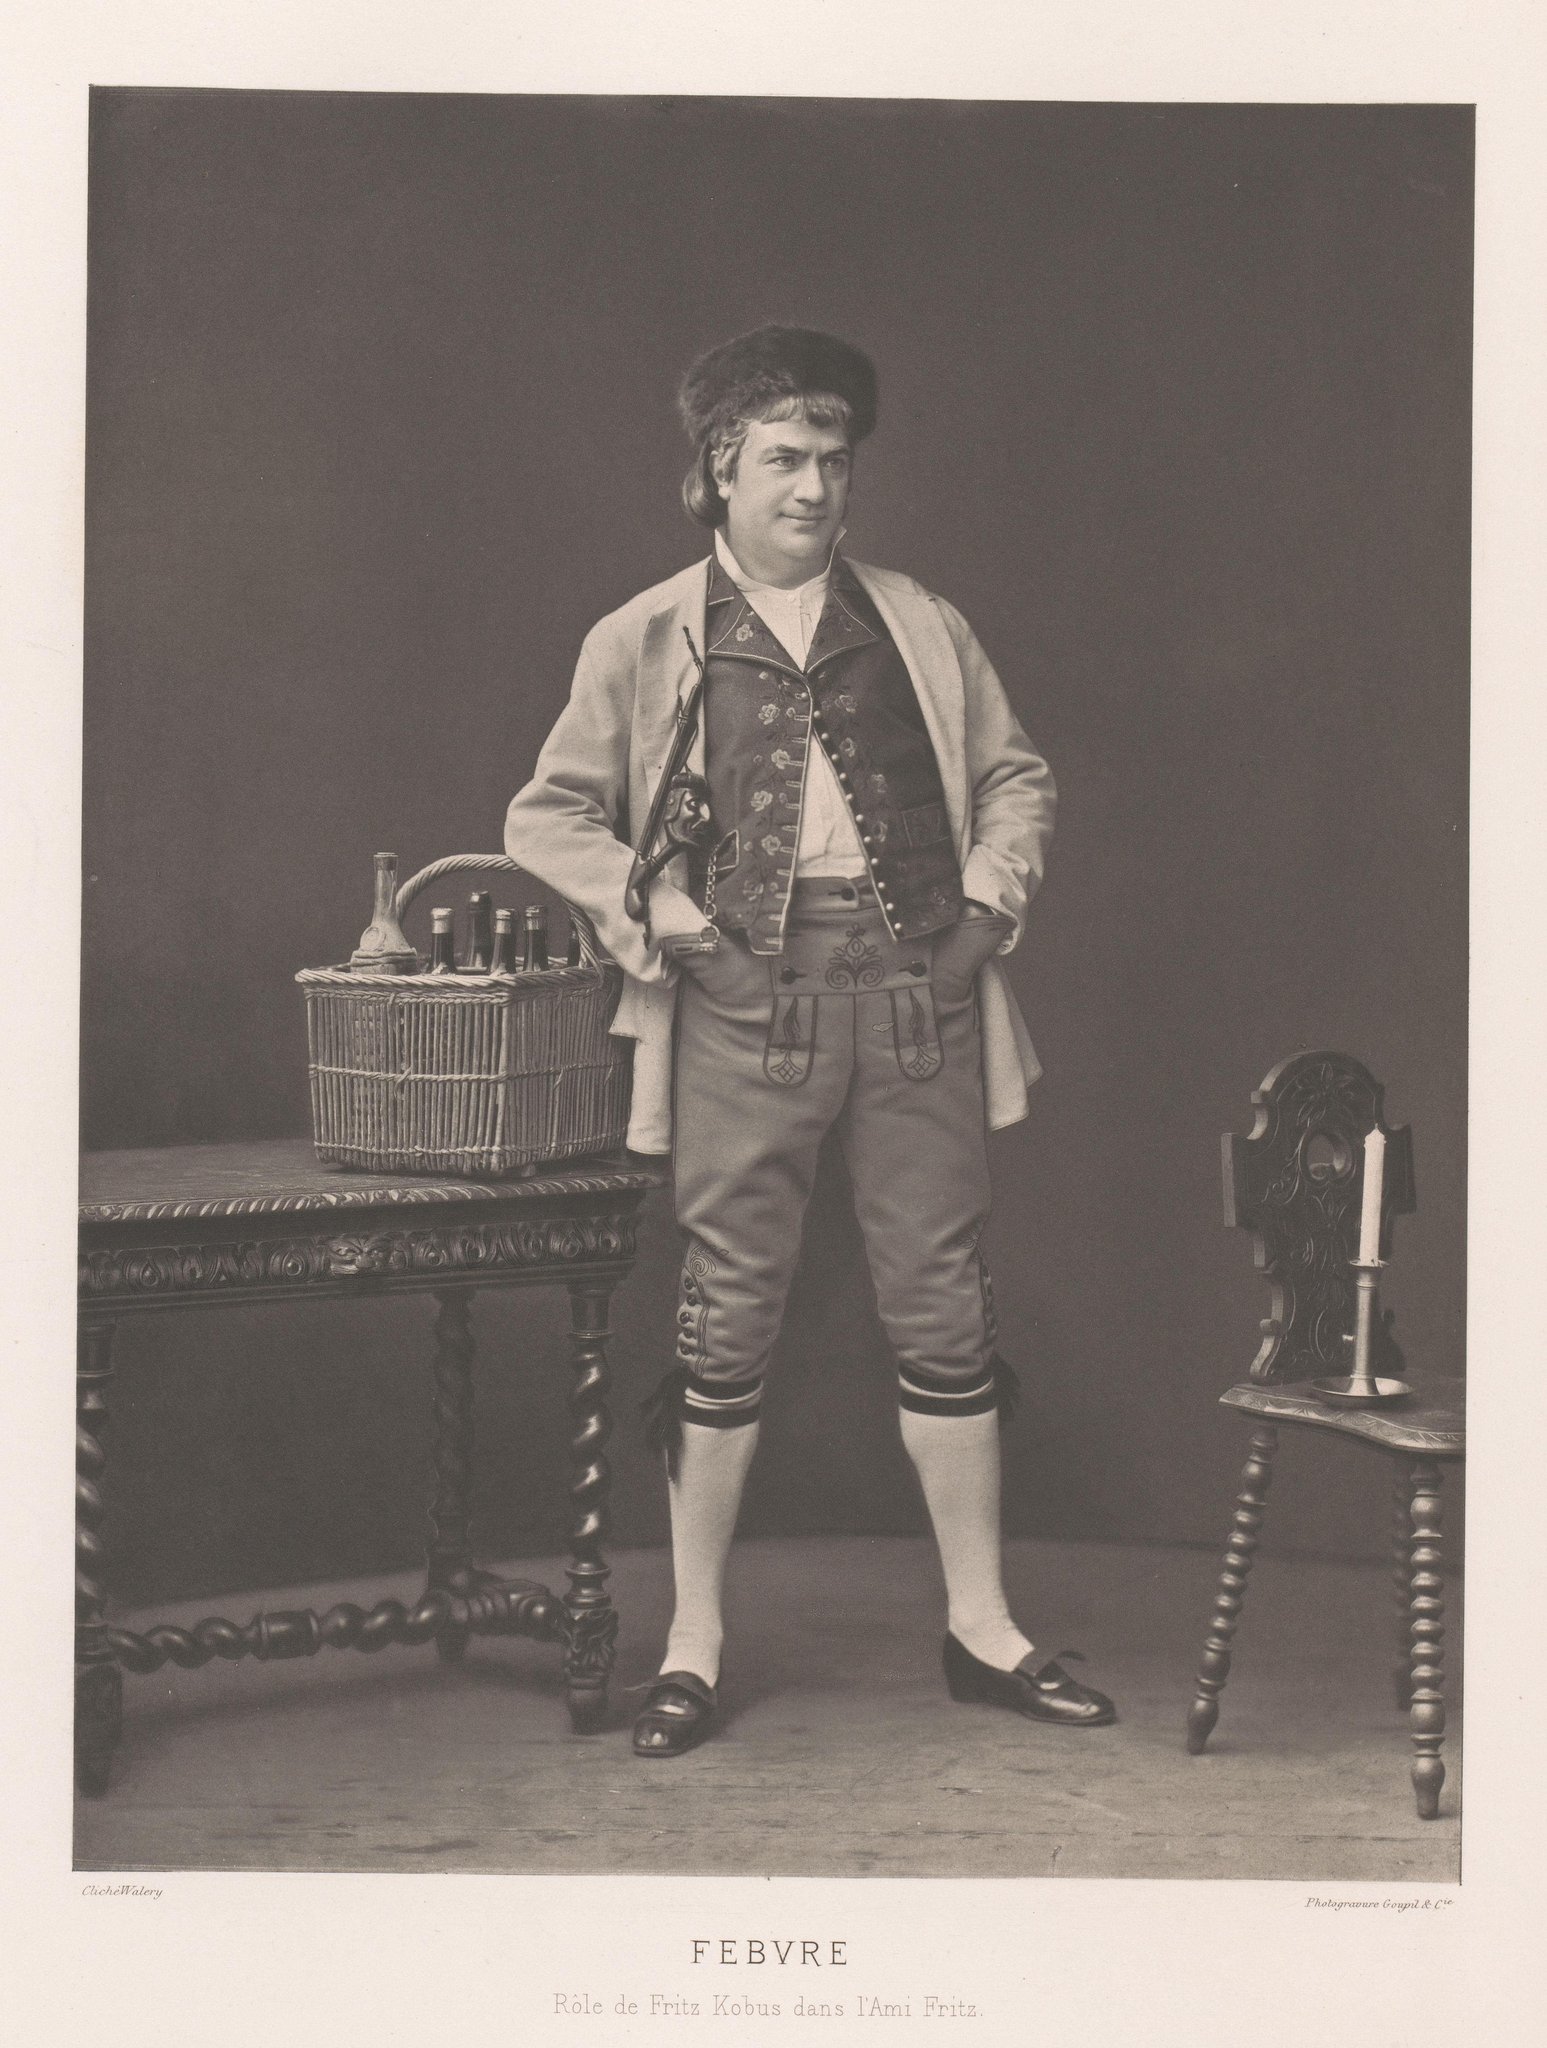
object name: page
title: Portret van Alexandre-Frédéric Febvre in de rol van Fritz Robus in L'Ami Fritz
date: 1875-1880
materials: paper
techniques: photoaquatint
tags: historical persons, portrait of actor, actress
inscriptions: inscription: ‘LA COMÉDIE FRANÇAISE’